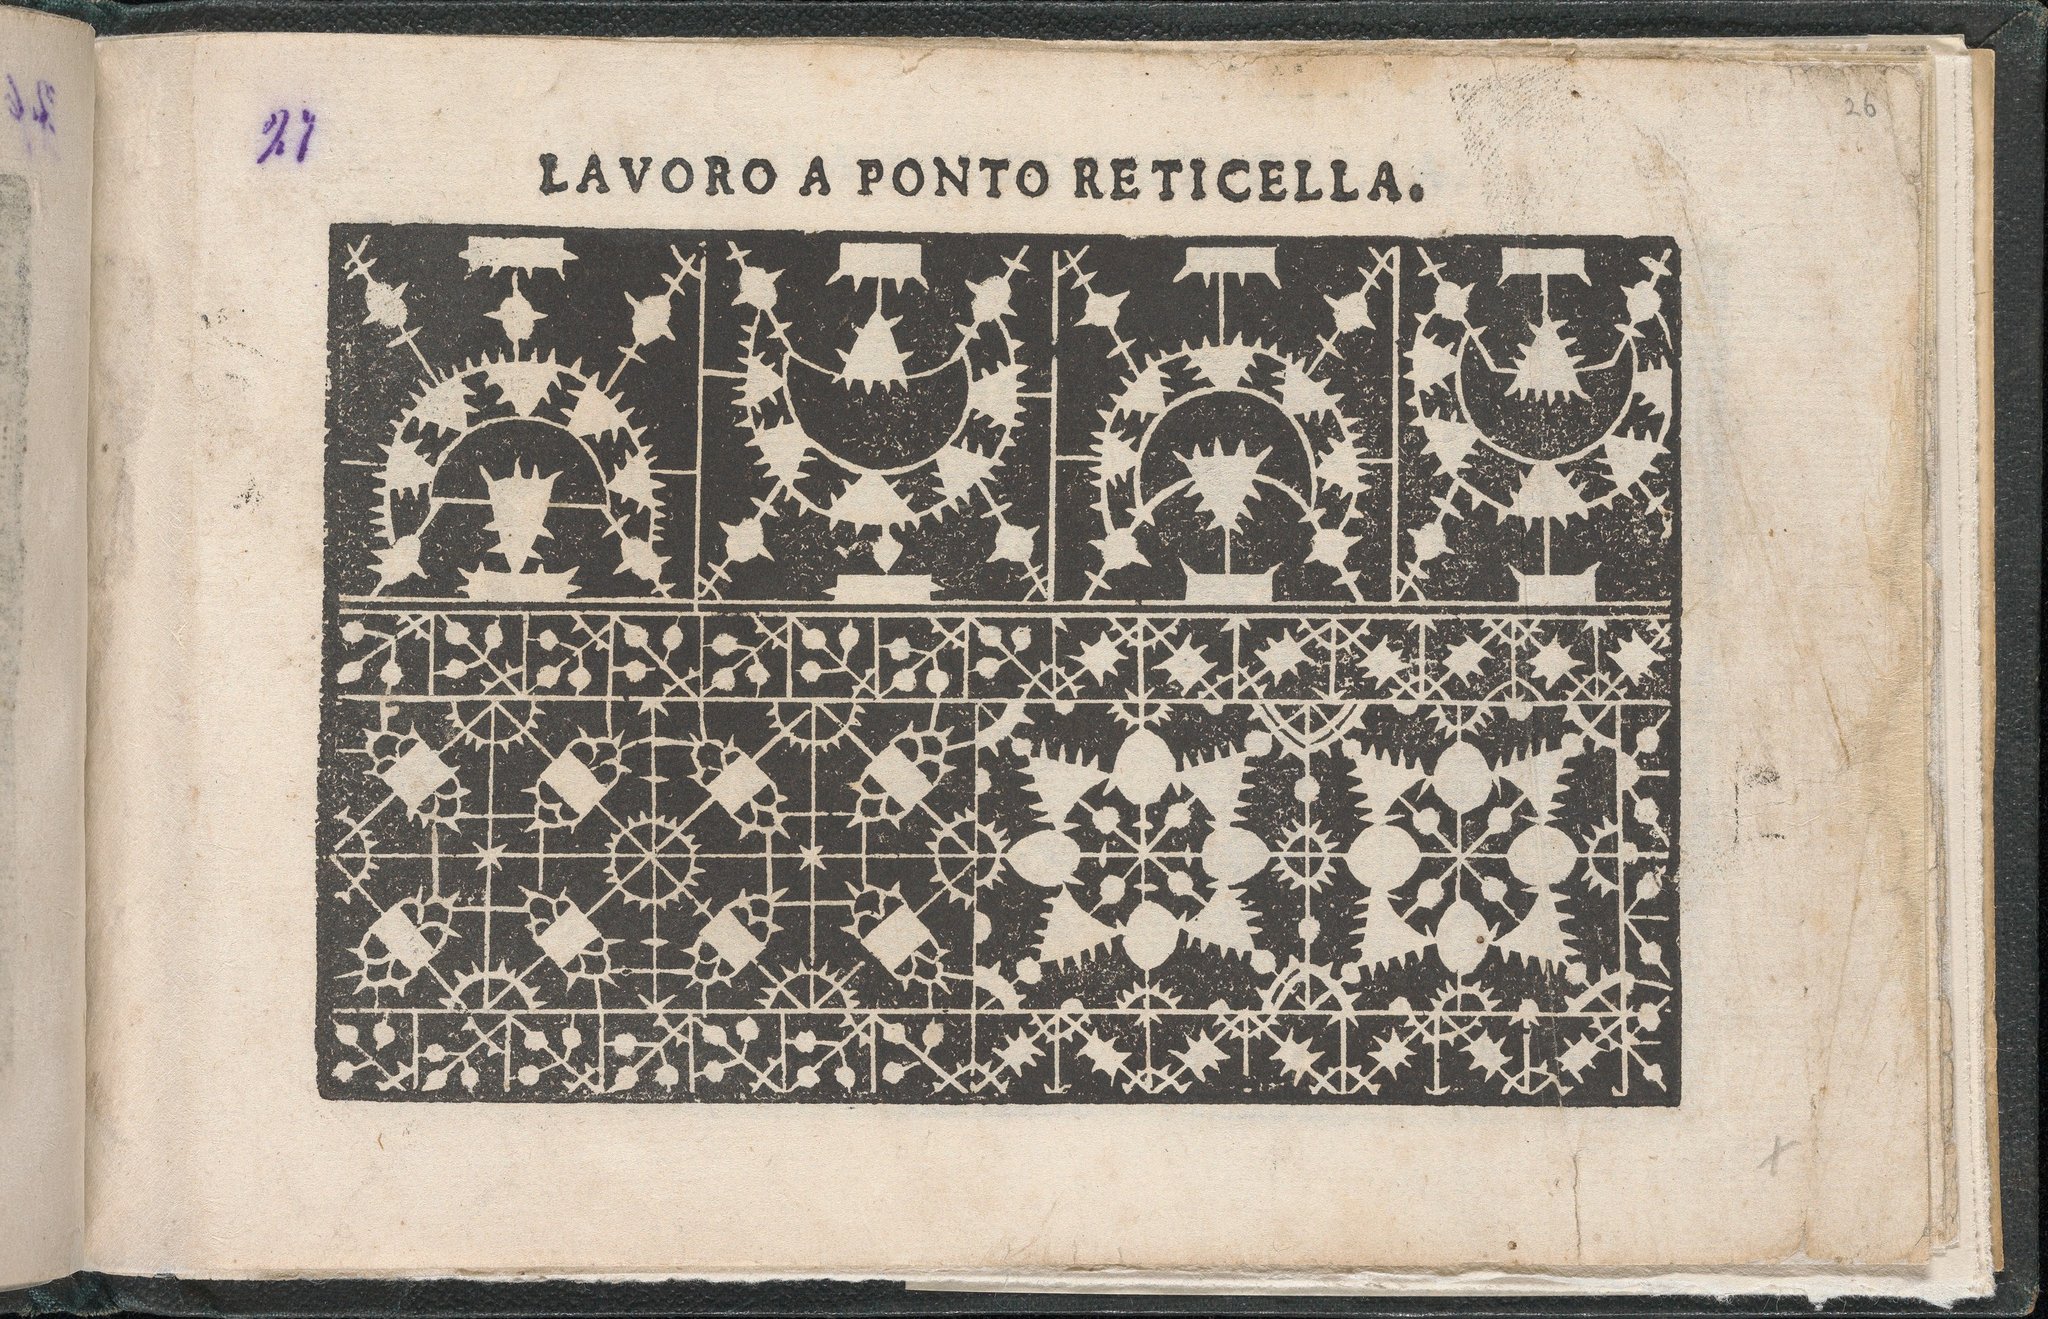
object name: book print ornament architecture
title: Gemma pretiosa della virtuose donne, page 26 (recto)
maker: isabella catanea parasole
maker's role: designer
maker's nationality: italian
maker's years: 1565-1625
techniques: woodcut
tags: ornament